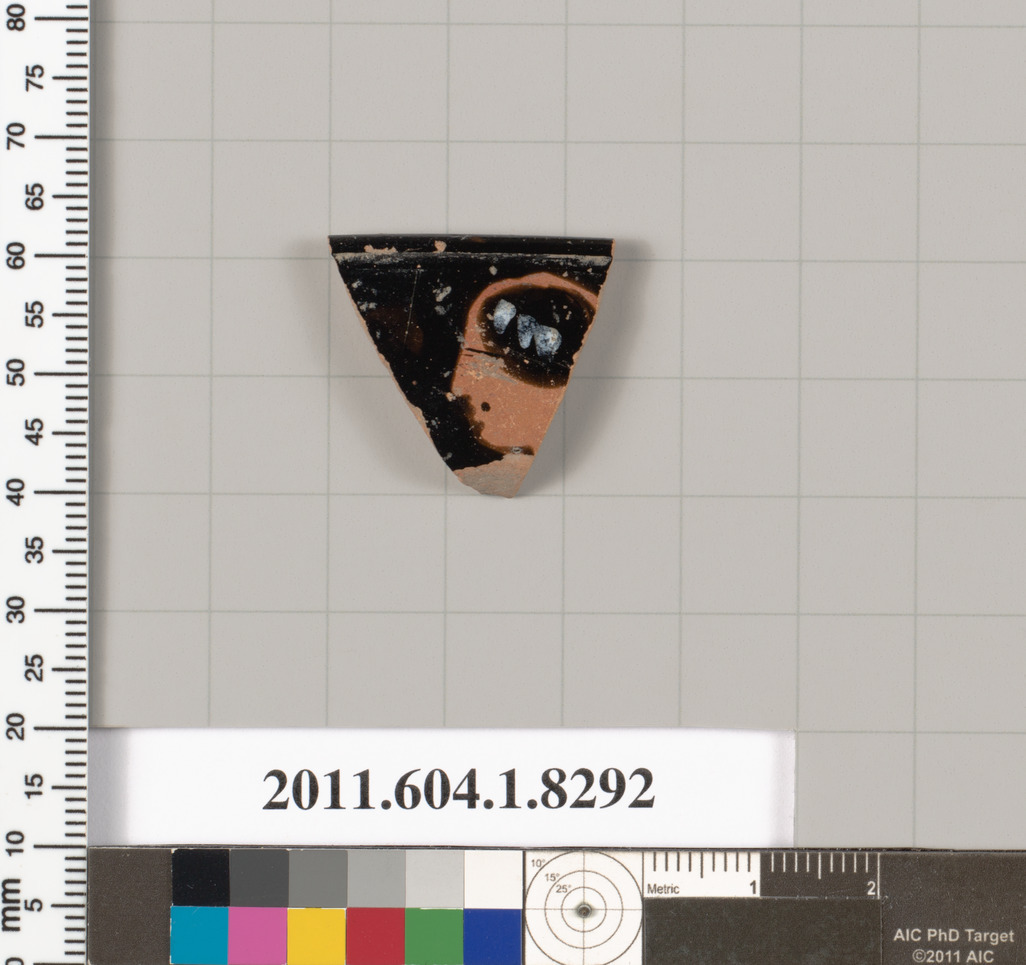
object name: kylix fragment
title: Terracotta rim fragment of a kylix (drinking cup)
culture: greek, attic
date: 400-376 BCE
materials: terracotta